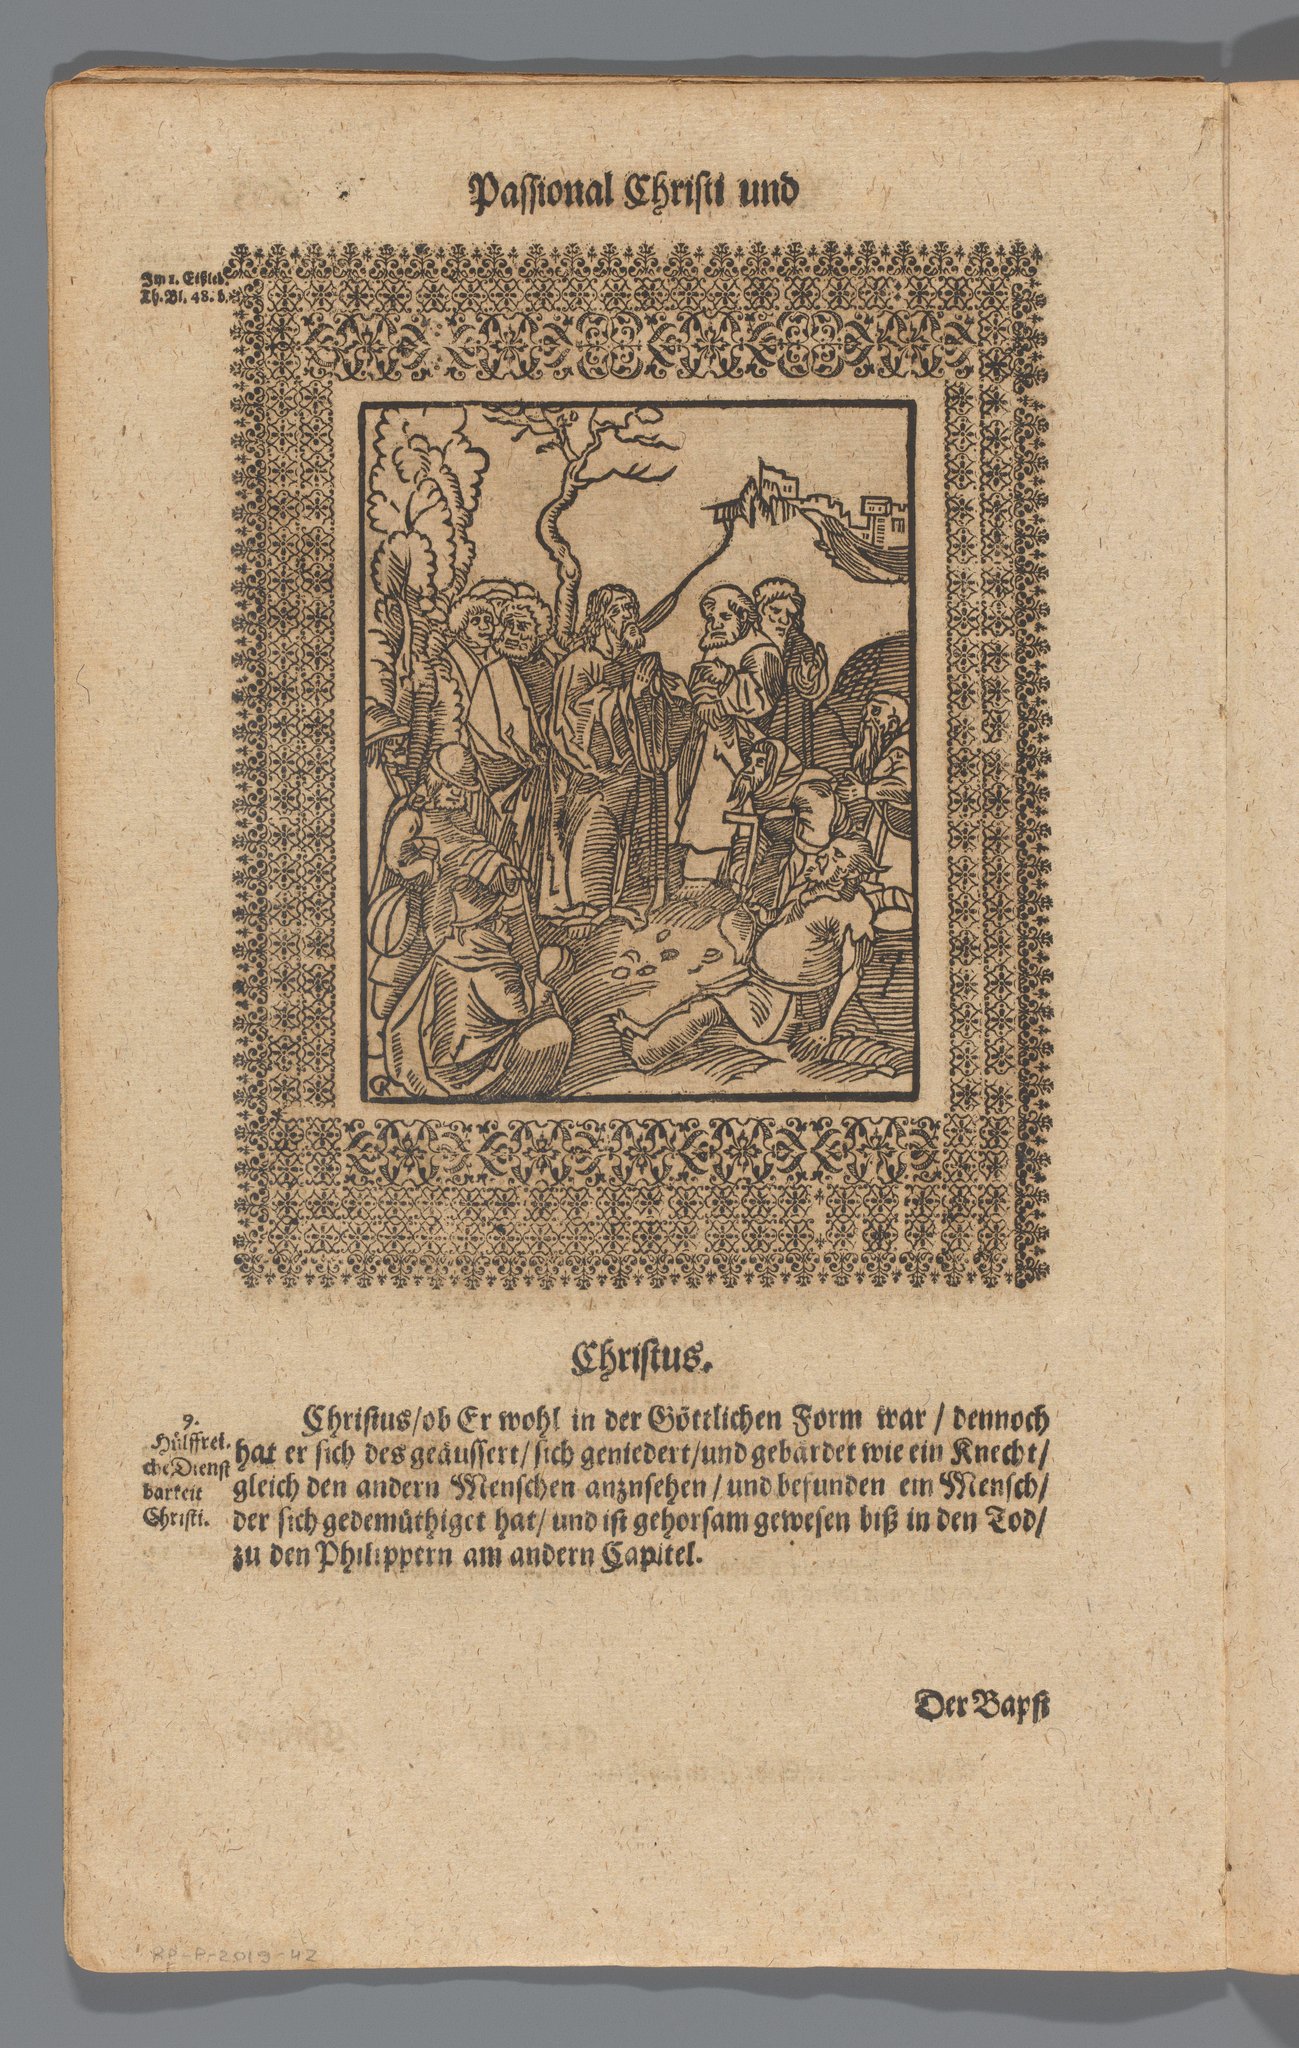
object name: print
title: Christus geneest kreupelen en melaatsen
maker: monogrammist gk (prentmaker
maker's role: print maker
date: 1661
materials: paper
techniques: letterpress printing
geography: europe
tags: the richness of the church opposed to christ's humility, disabilities, deformations, miracles of christ ~ healing the sick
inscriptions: collector's mark: Lugt 2228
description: Christus geneest mensen met lepra en lichamelijke beperkingen. Tegenstelling over activiteiten. Spiegelbeeldige kopie naar de prent van Lucas Cranach in het pamflet 'Passional Christi und Antichristi' van Martin Luther uit 1521, bladzijde uit een 17e-eeuwse uitgave. De reeks van dertien paar houtsneden geeft de tegenstellingen weer tussen de nederigheid en onbaatzuchtigheid van Christus enerzijds, en de trots en hebzucht van de paus anderzijds.